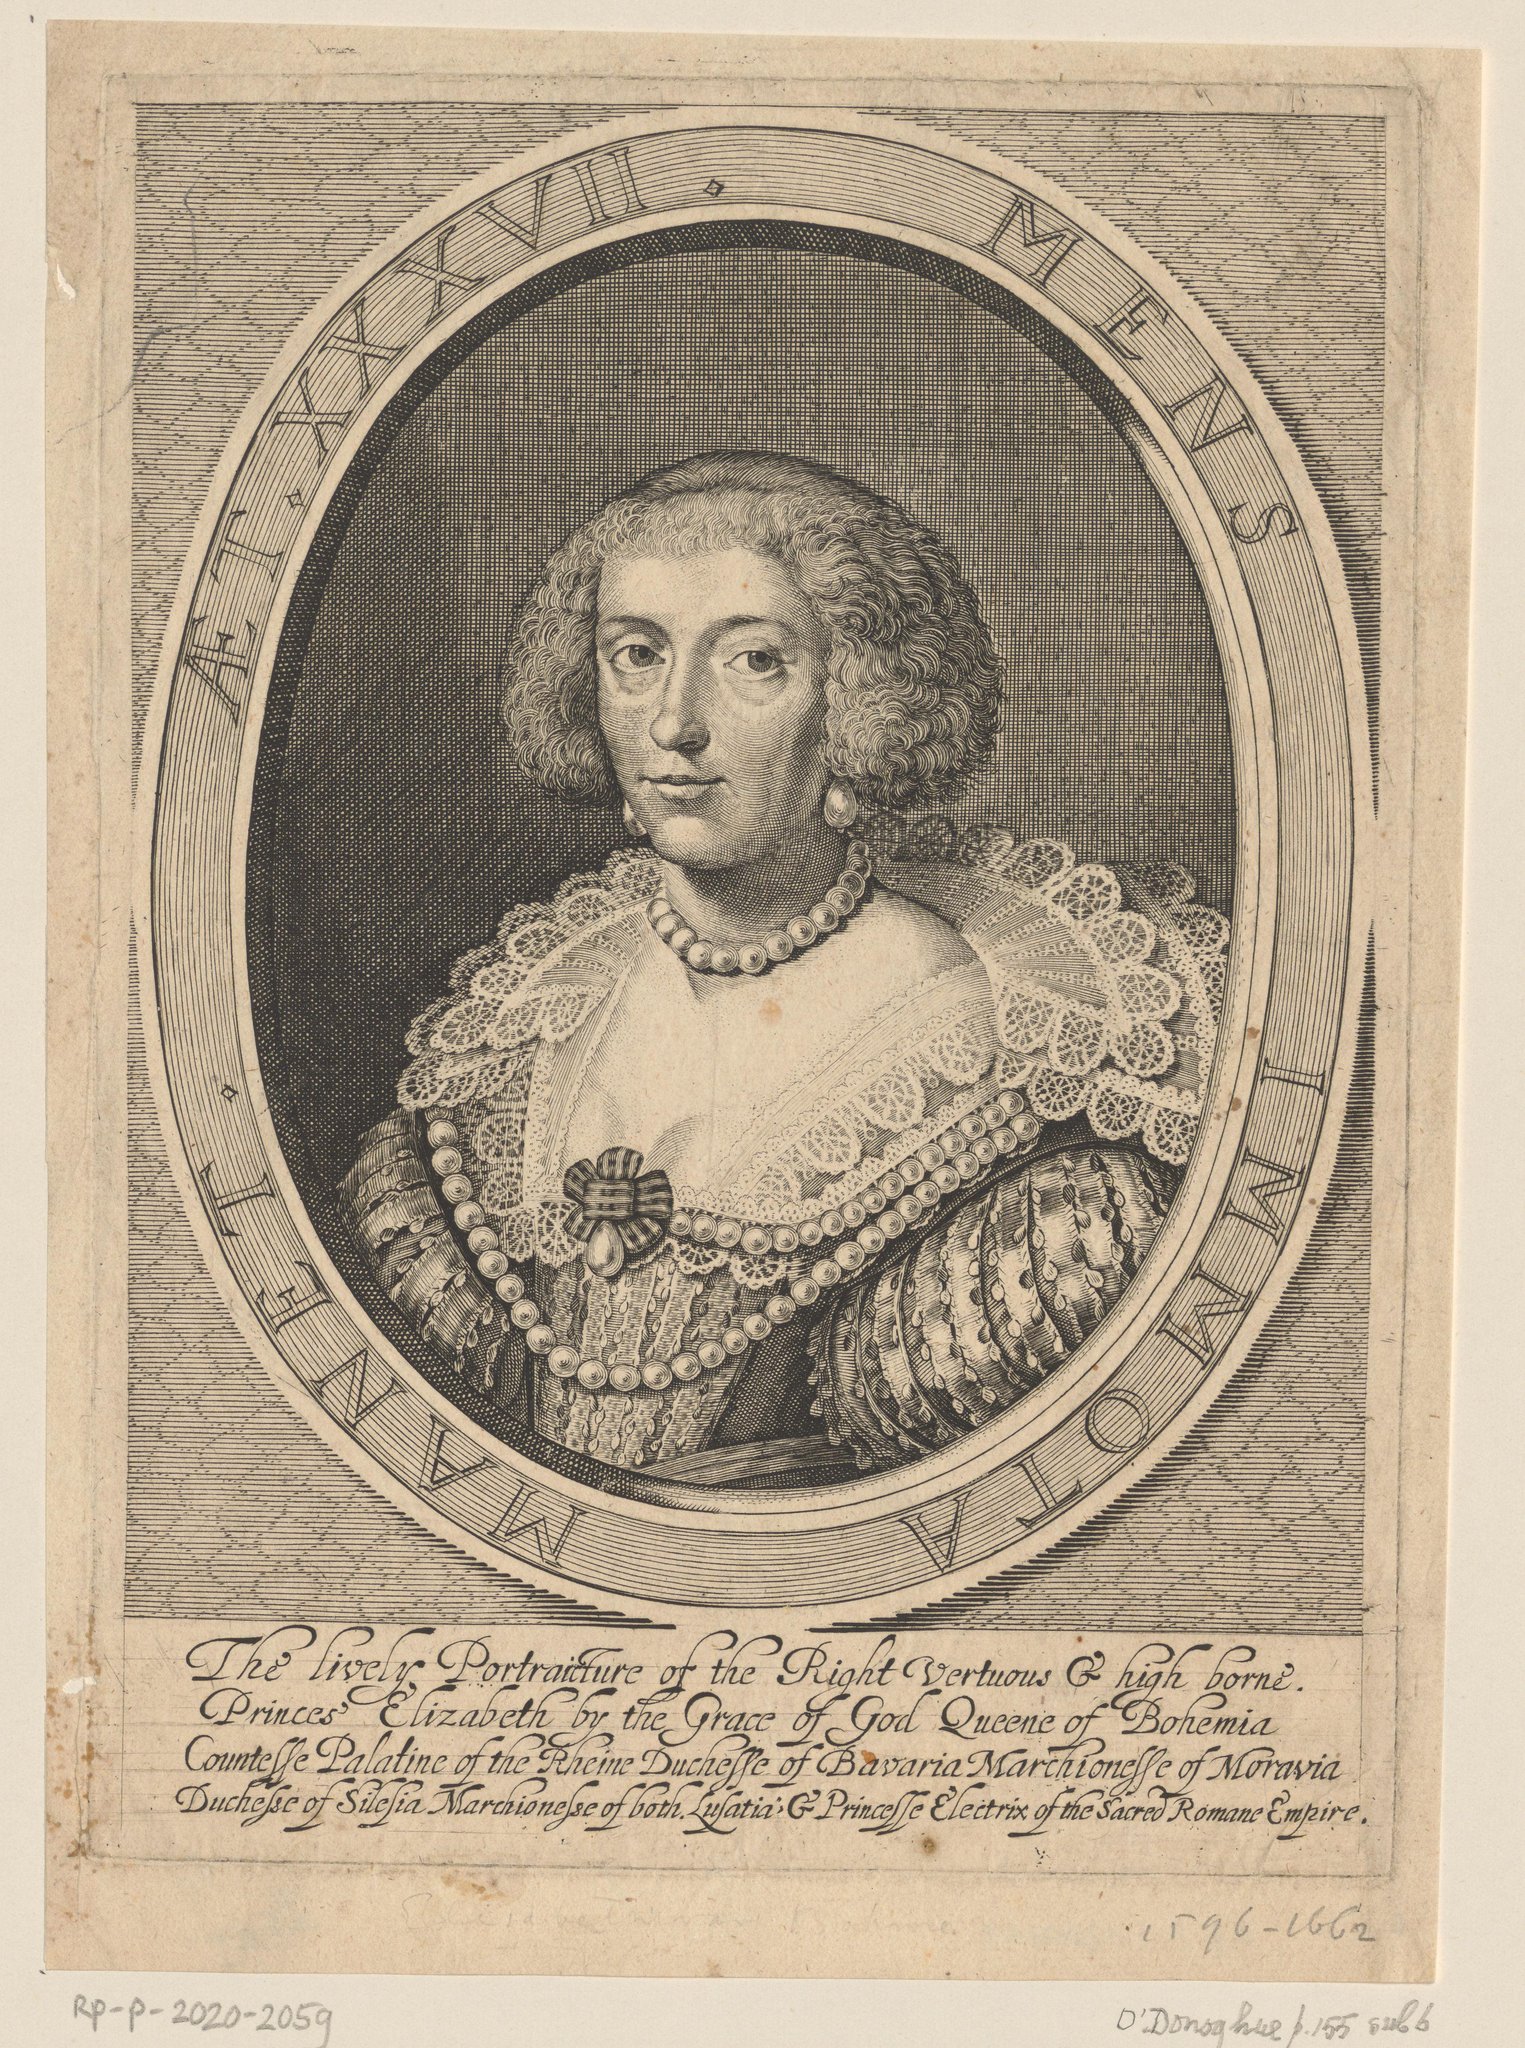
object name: print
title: Portret van Elisabeth Stuart op 37-jarige leeftijd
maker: Anonymous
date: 1633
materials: paper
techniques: engraving, etching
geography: england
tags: london, historical persons - bb - woman, pearl; pearl necklace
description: Met vierregelig onderschrift in het Engels.